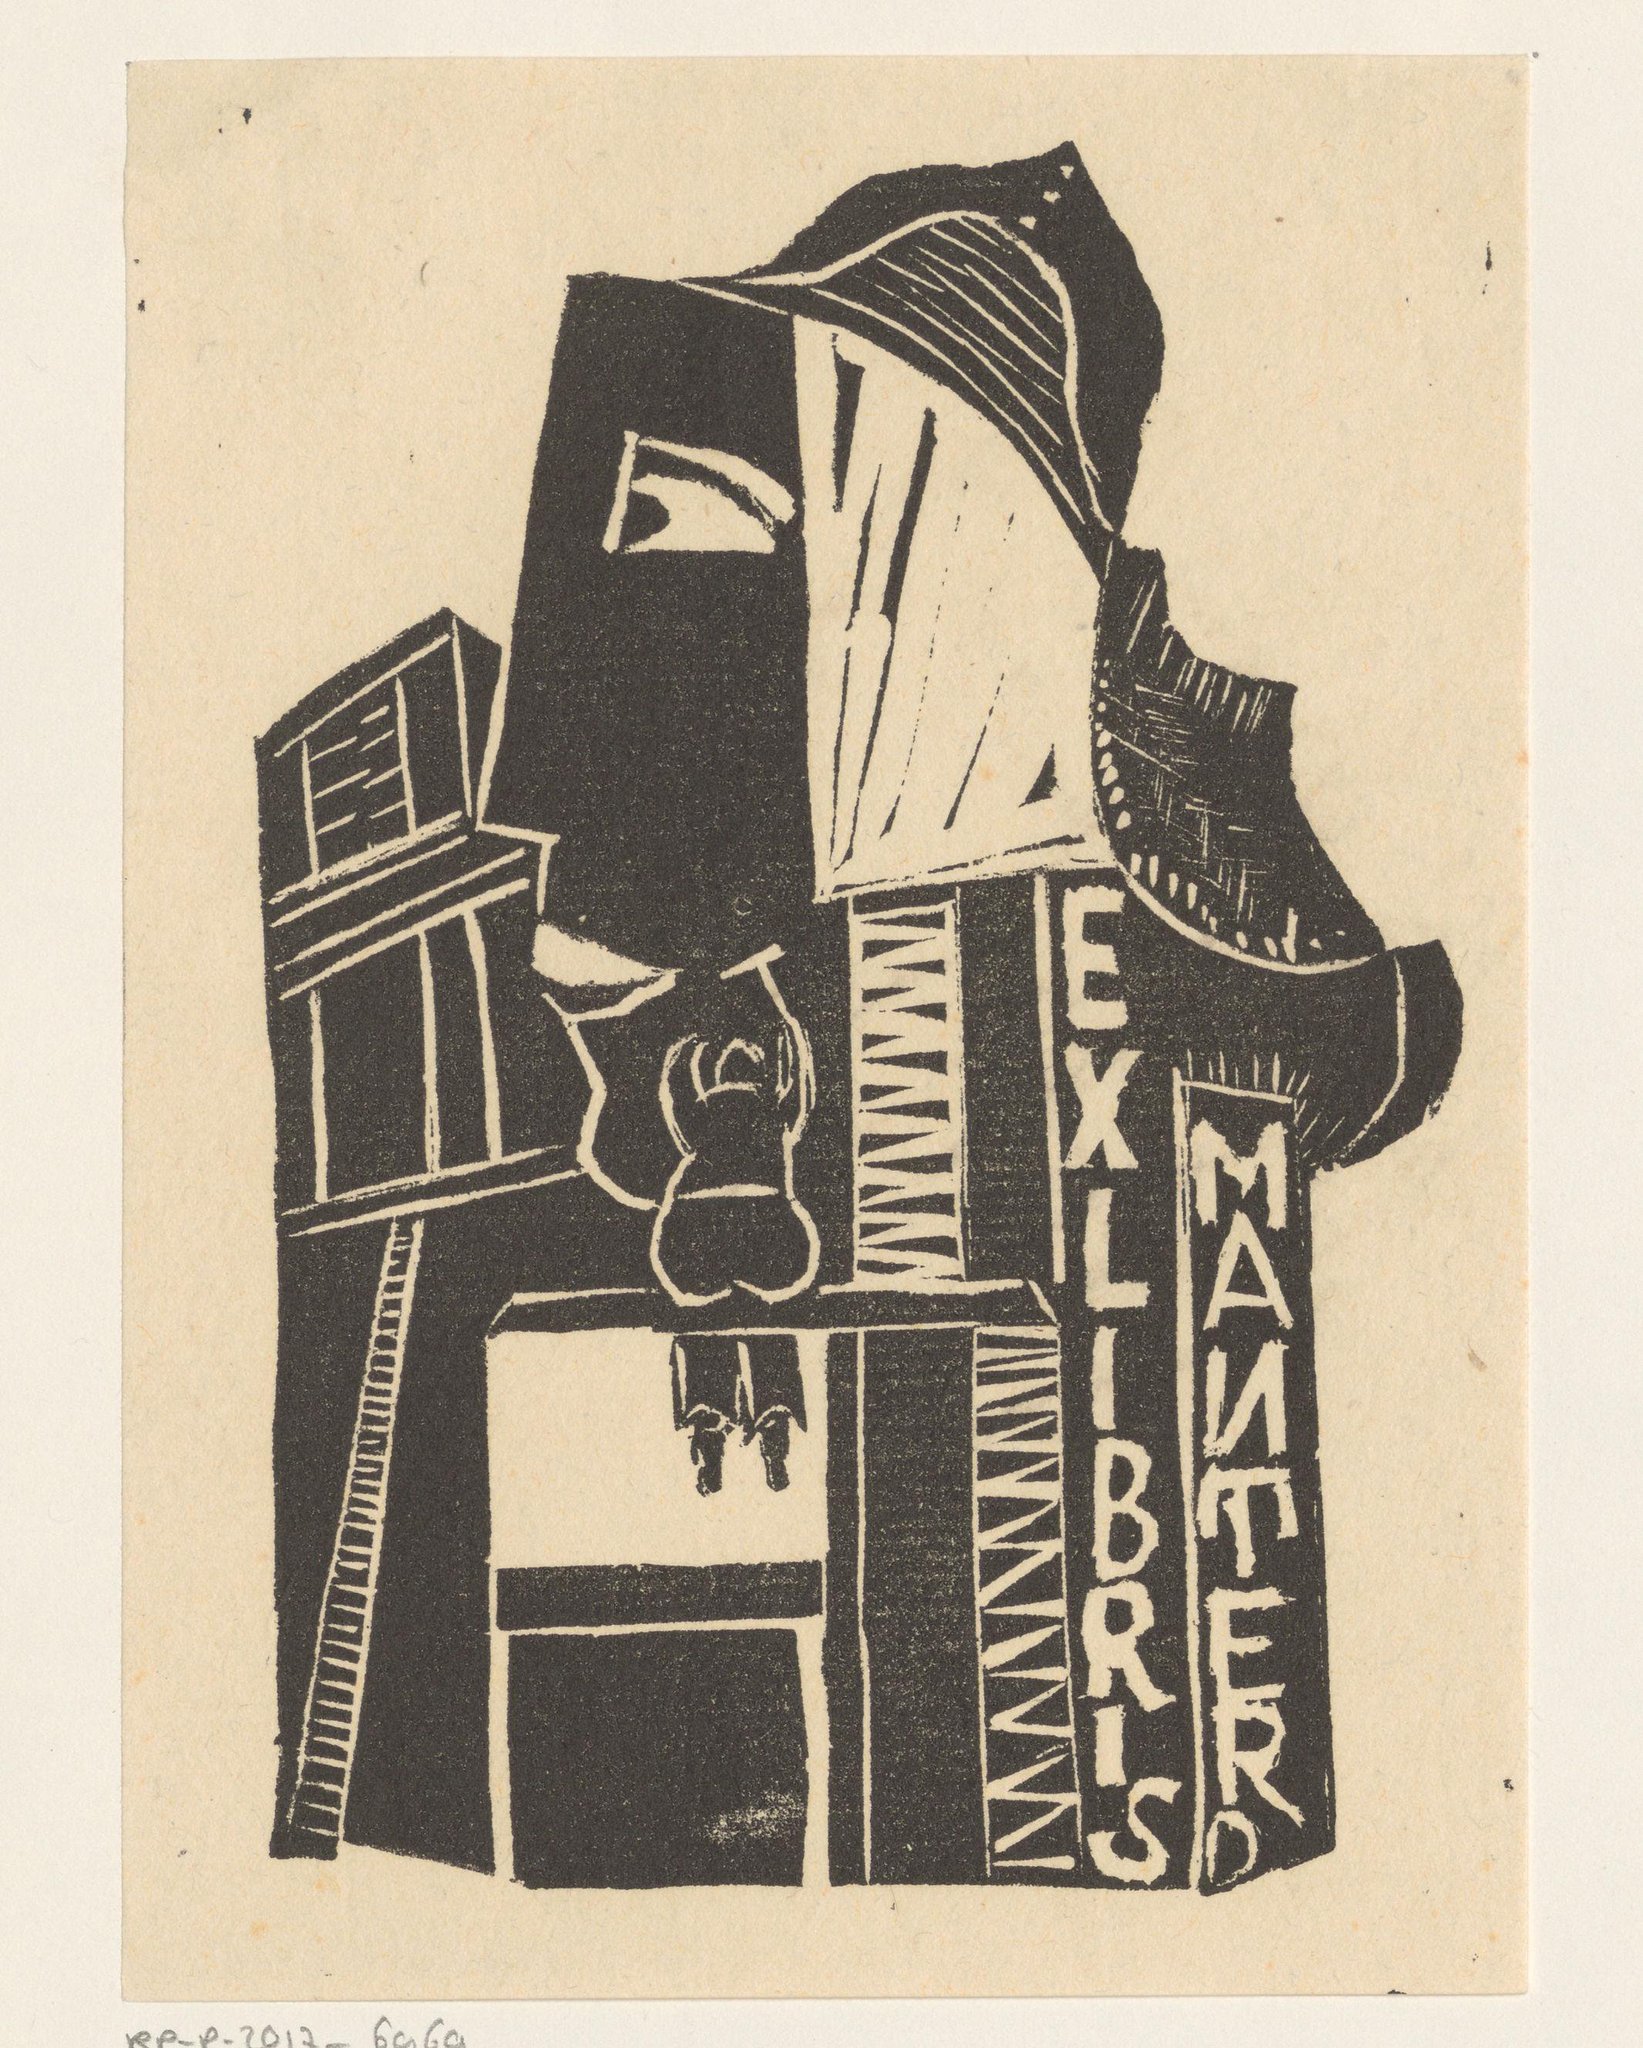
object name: bookplate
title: Ex libris van Gianni Mantero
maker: erna levy friedländer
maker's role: print maker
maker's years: 1890-1979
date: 1907-1979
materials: paper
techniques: woodcut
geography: austria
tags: gianni mantero, face, mason at work